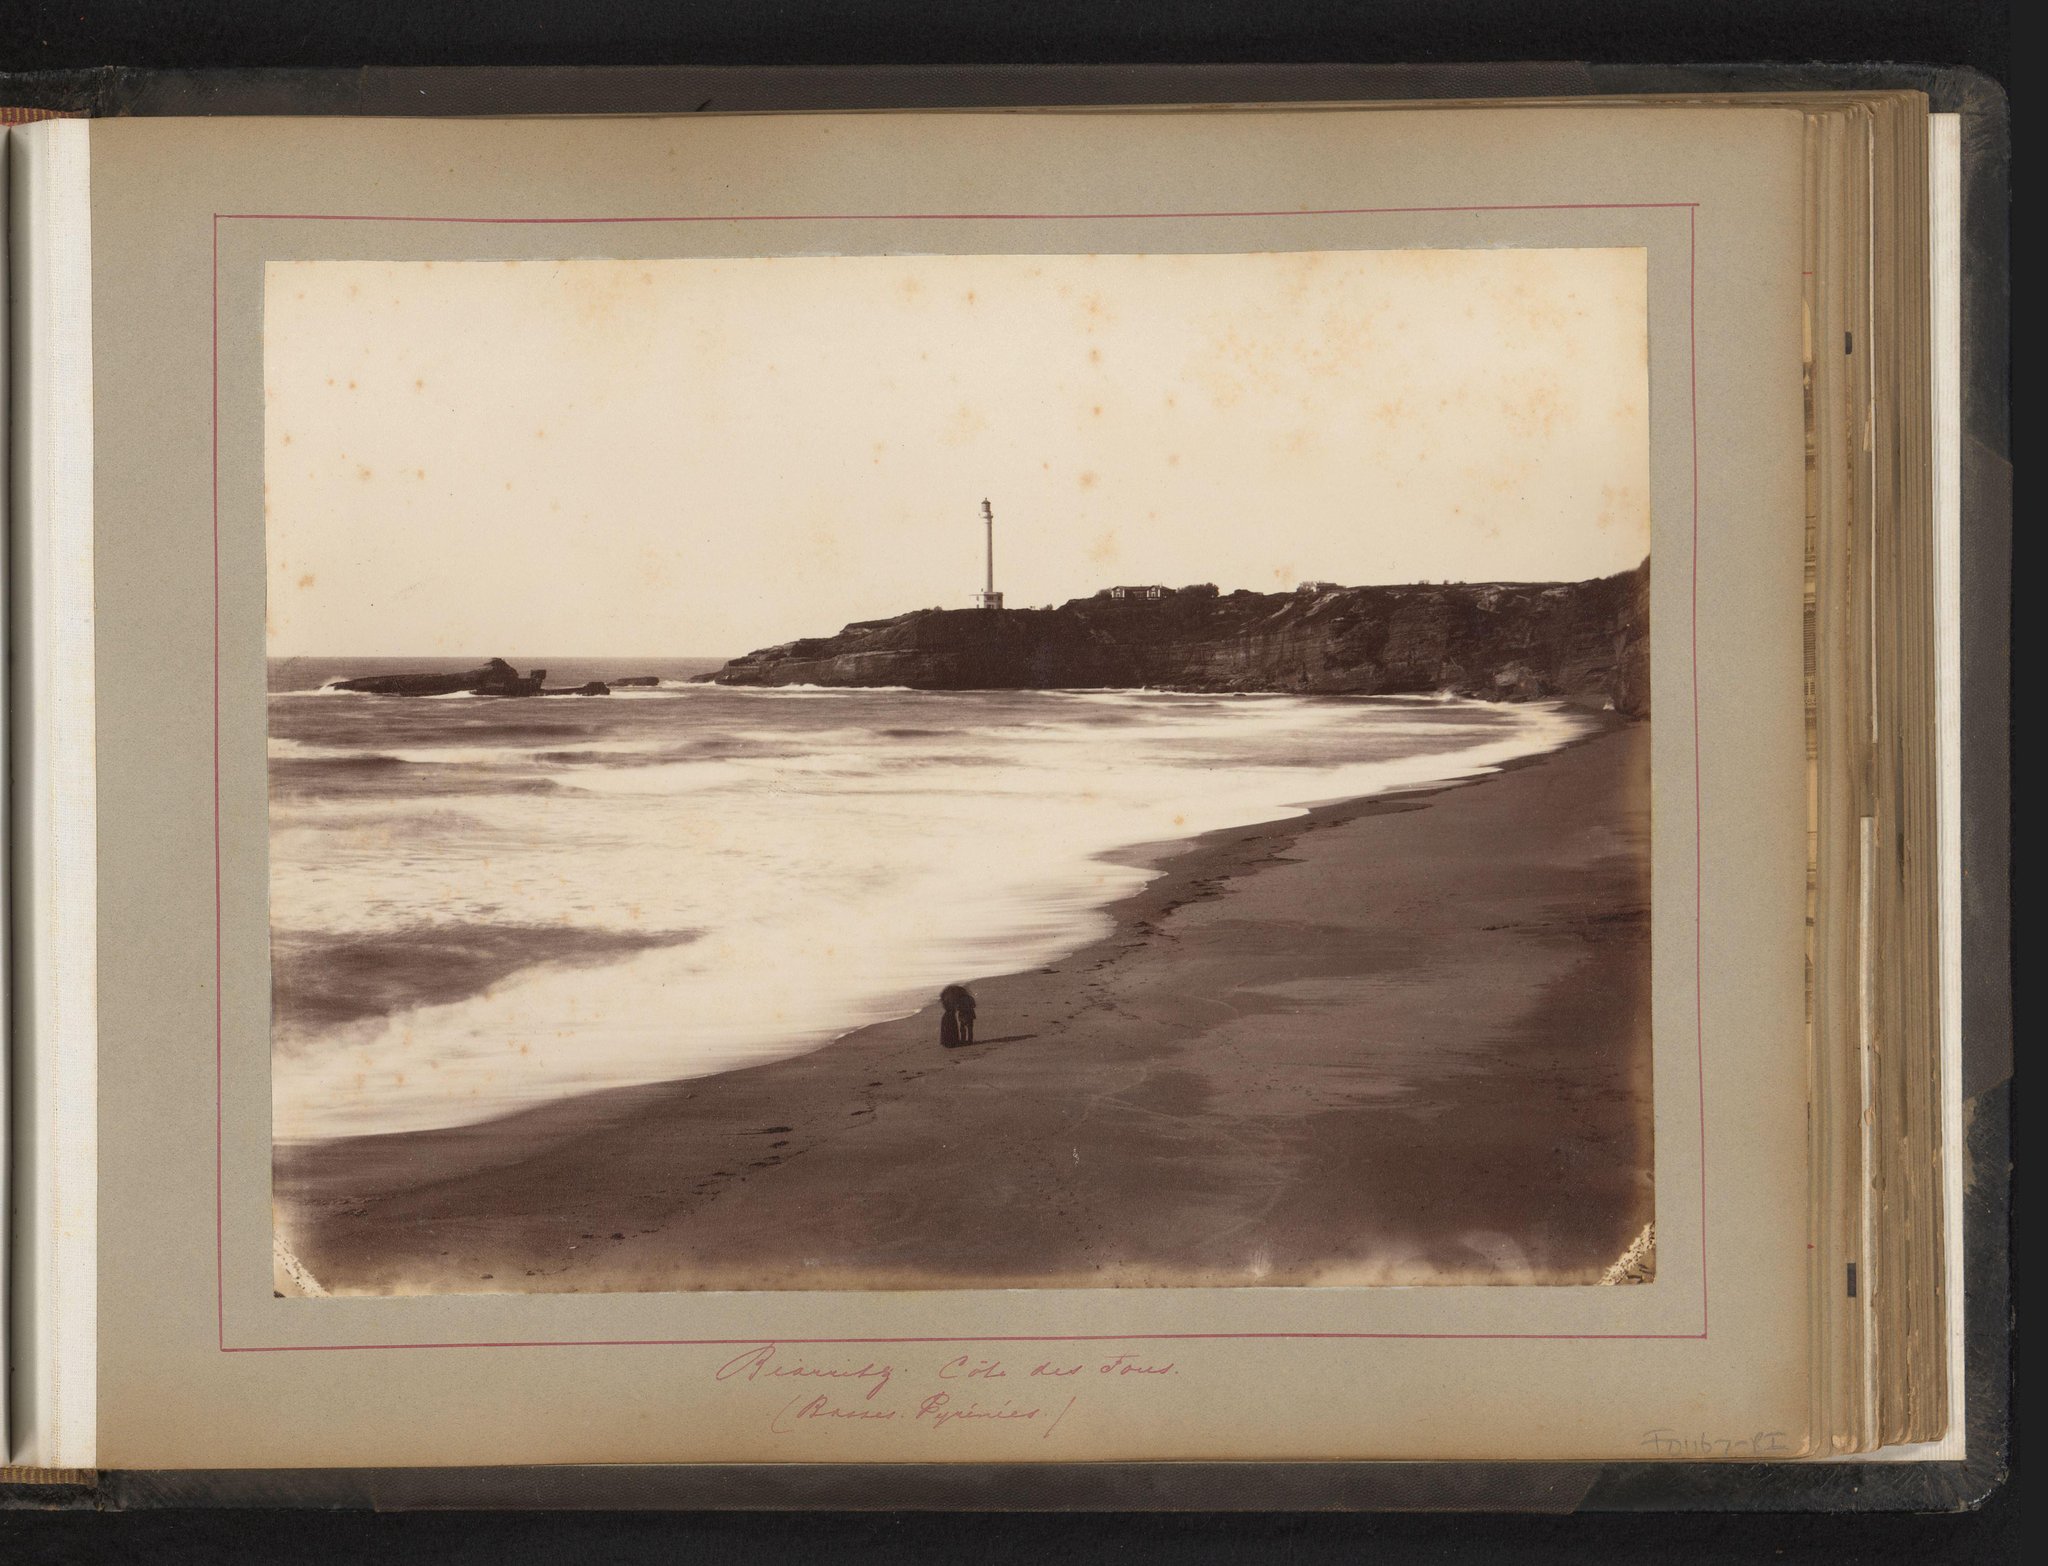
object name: photograph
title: Côte des Fous met vuurtoren bij Biarritz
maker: Anonymous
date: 1880-1910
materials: photographic support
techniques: albumen print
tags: lighthouse, lightship, beach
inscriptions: annotation: ‘Biarritz; Côte des Fous/ [...]’